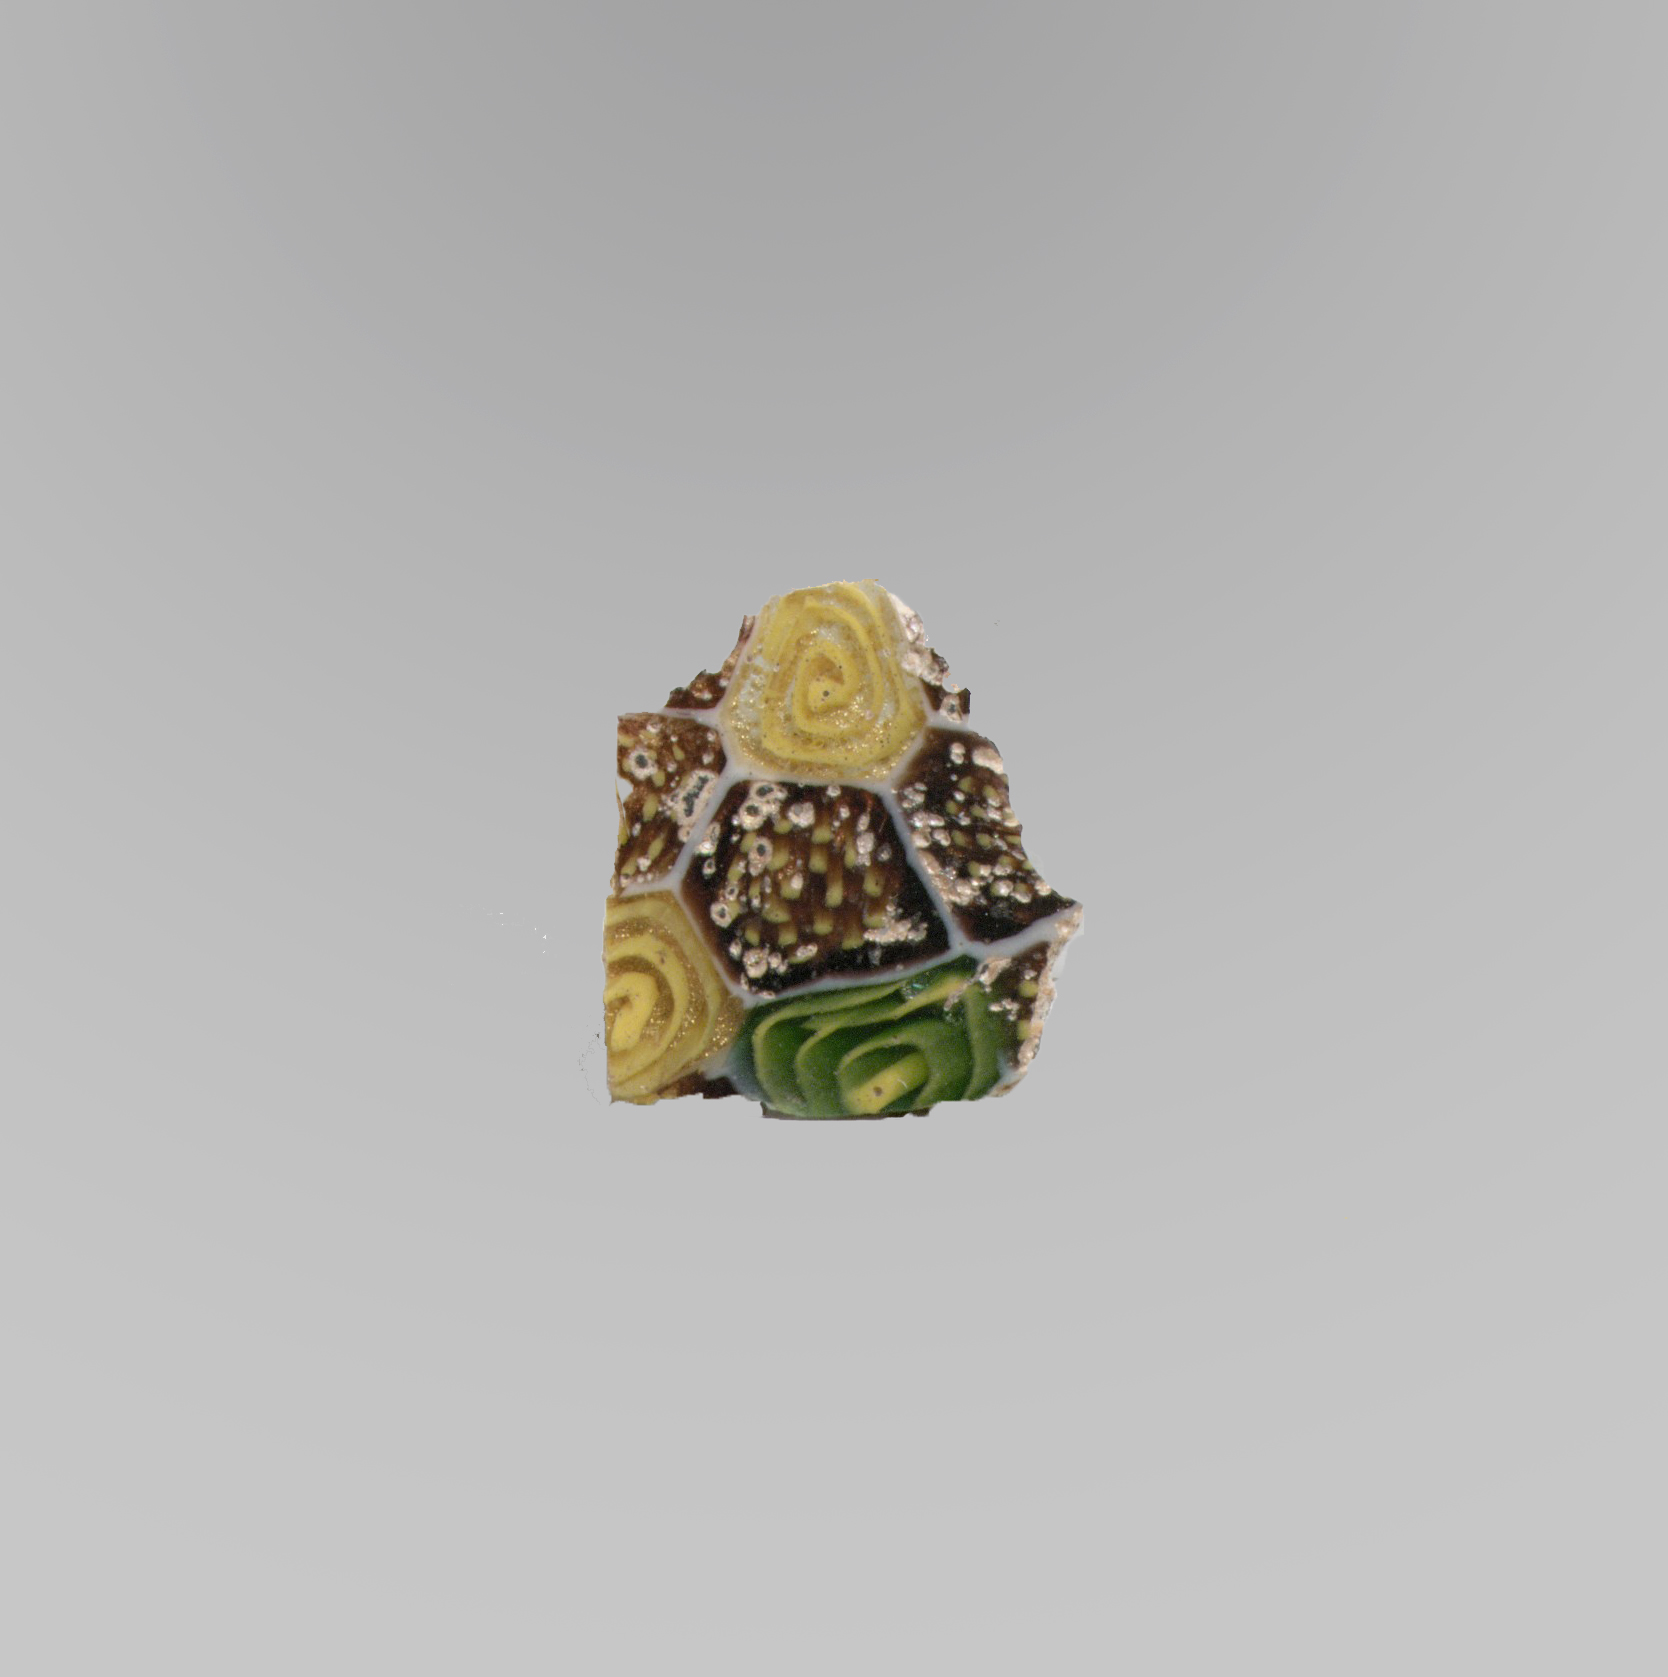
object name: fragment, mosaic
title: Glass mosaic fragment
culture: roman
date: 34 BCE-33 CE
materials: glass